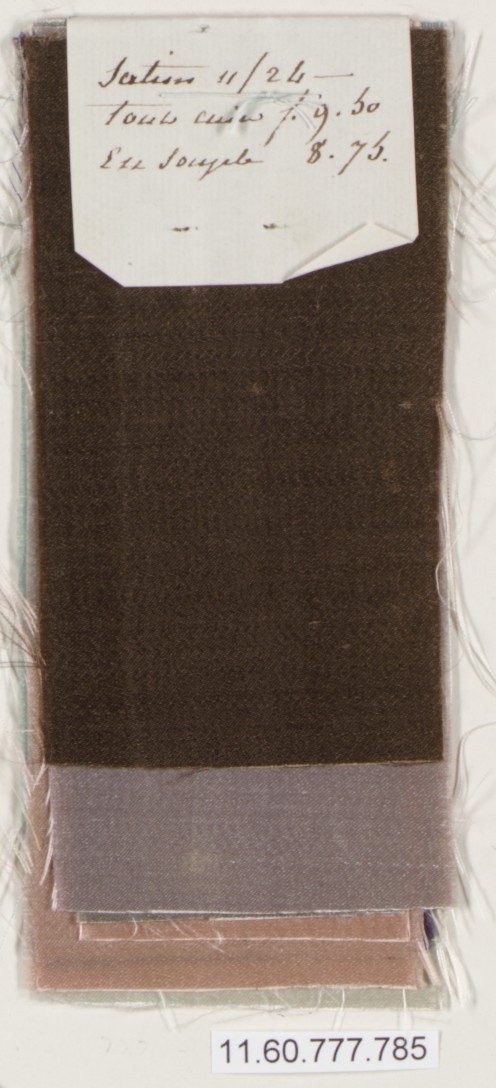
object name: sample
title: Samples (9)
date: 1801-1833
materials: silk